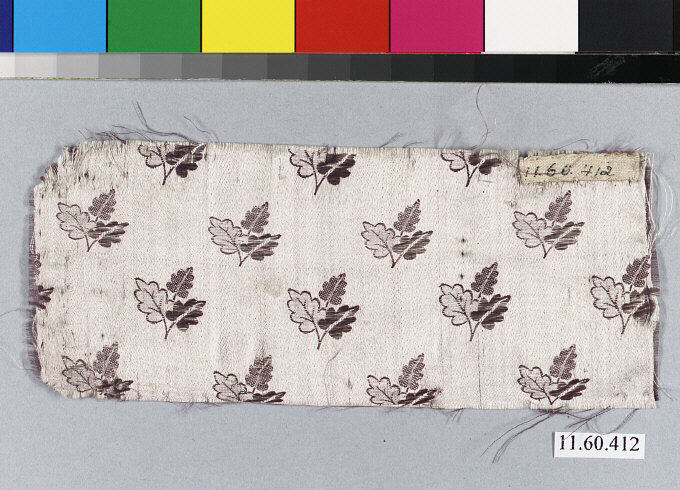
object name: fragment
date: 1801-1900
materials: silk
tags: leaves